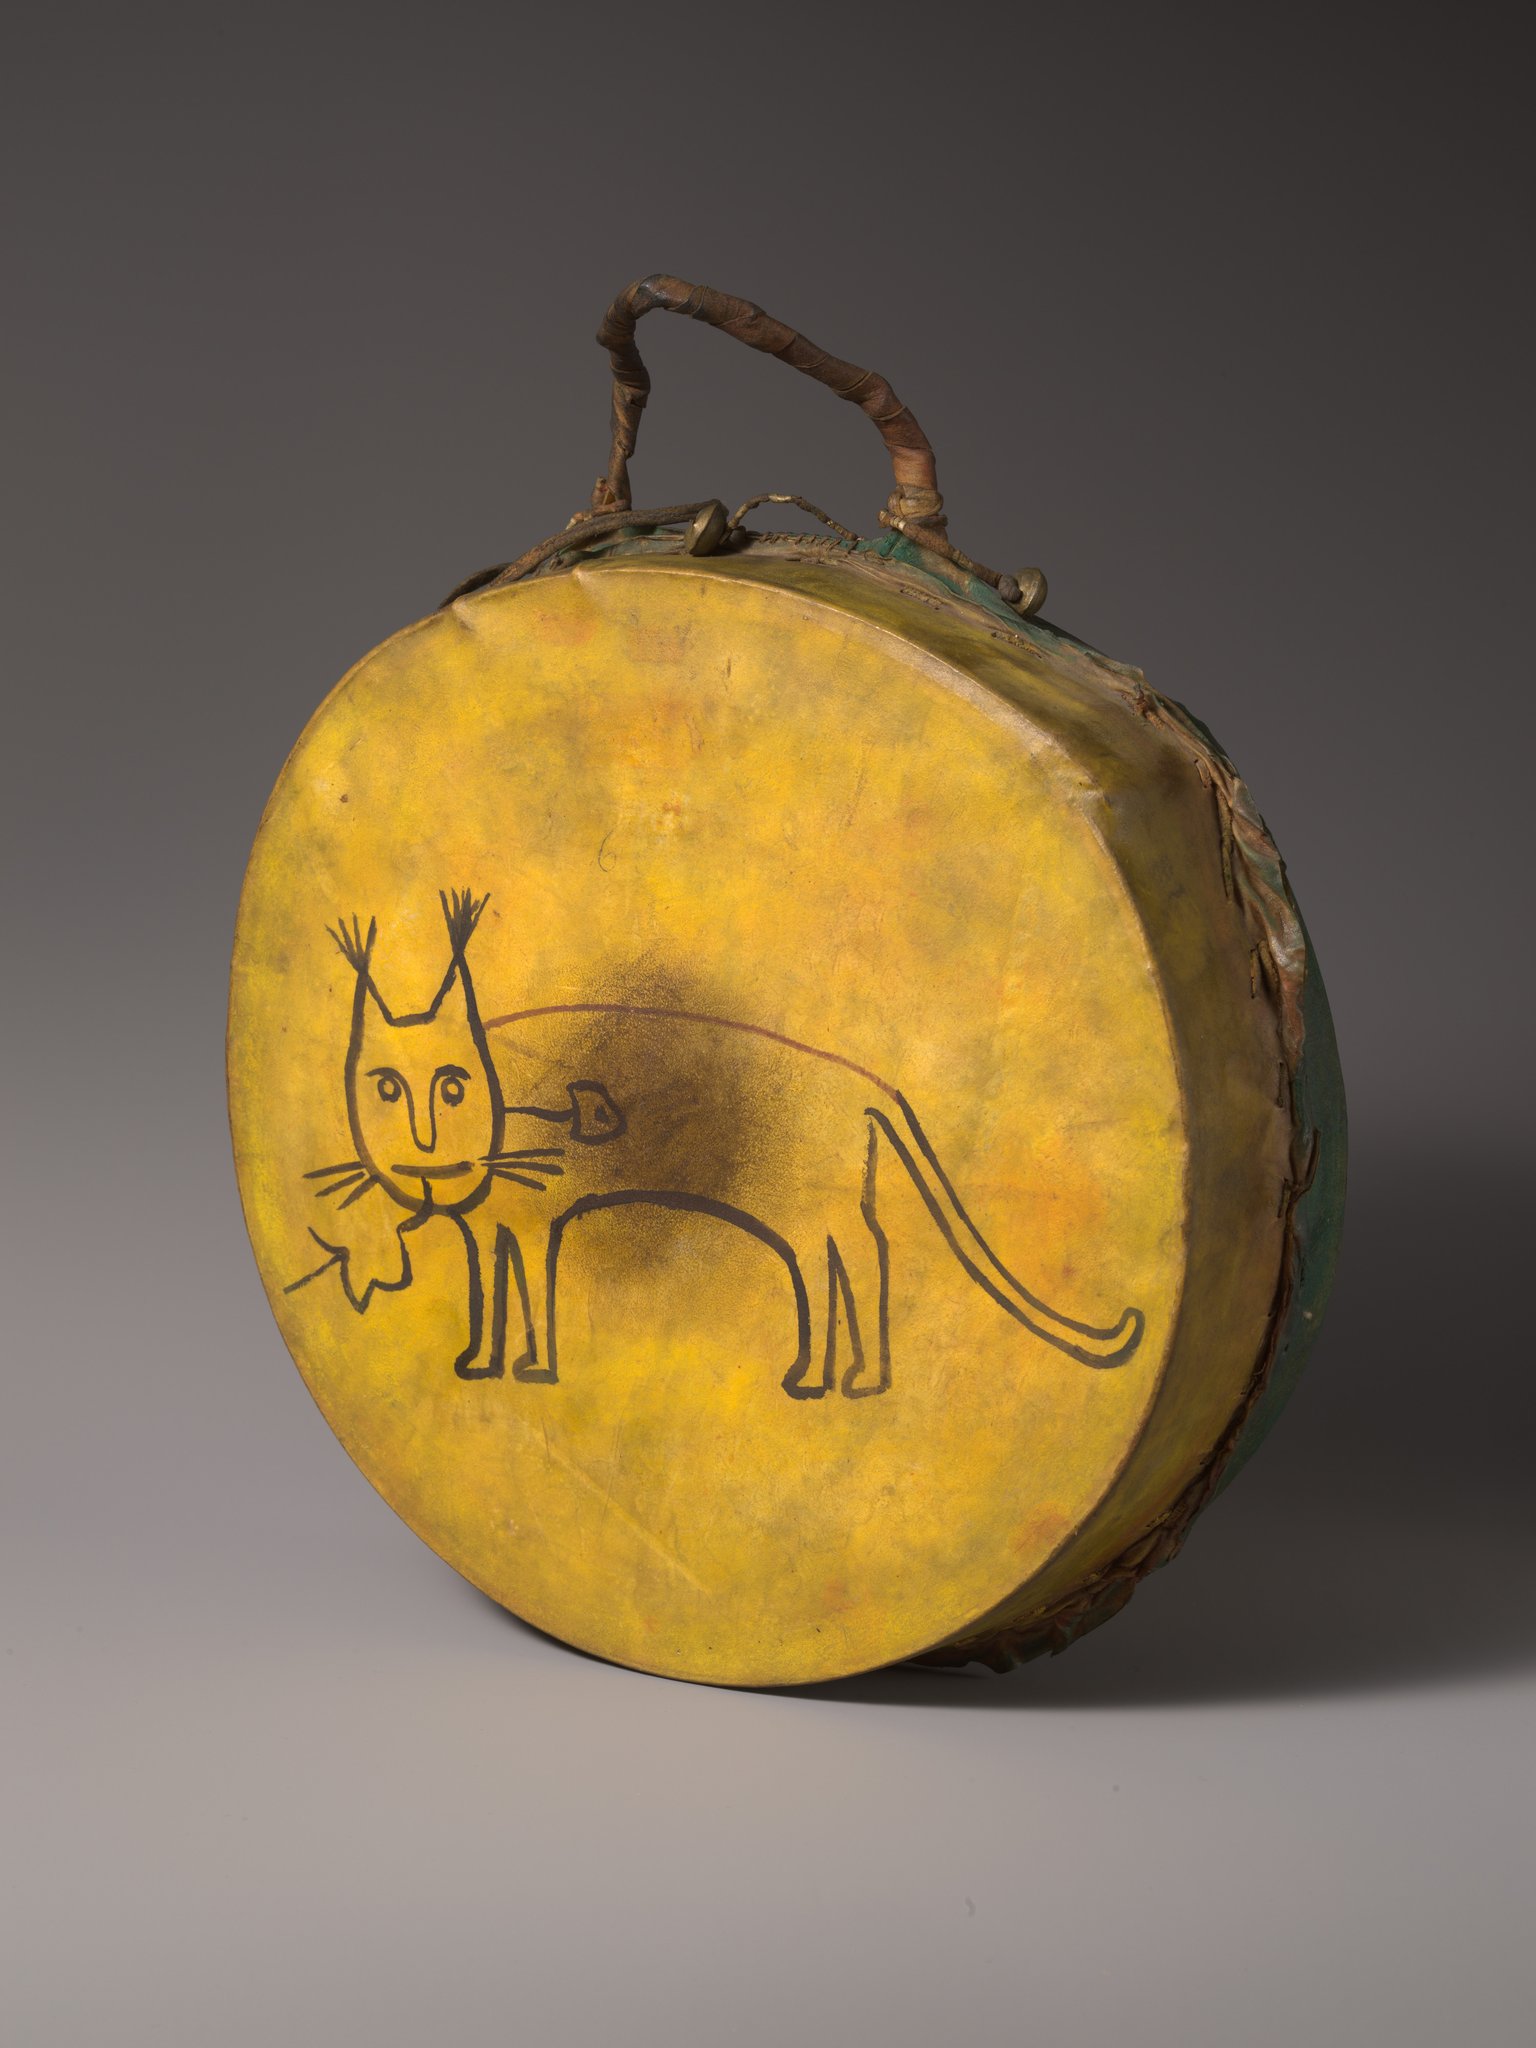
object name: wakan chan cha gha frame drum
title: Wakan-chan-cha-gha (frame drum)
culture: native american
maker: sioux or dakota tribe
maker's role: maker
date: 1867-1900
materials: skin, wood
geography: united states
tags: birds,cats